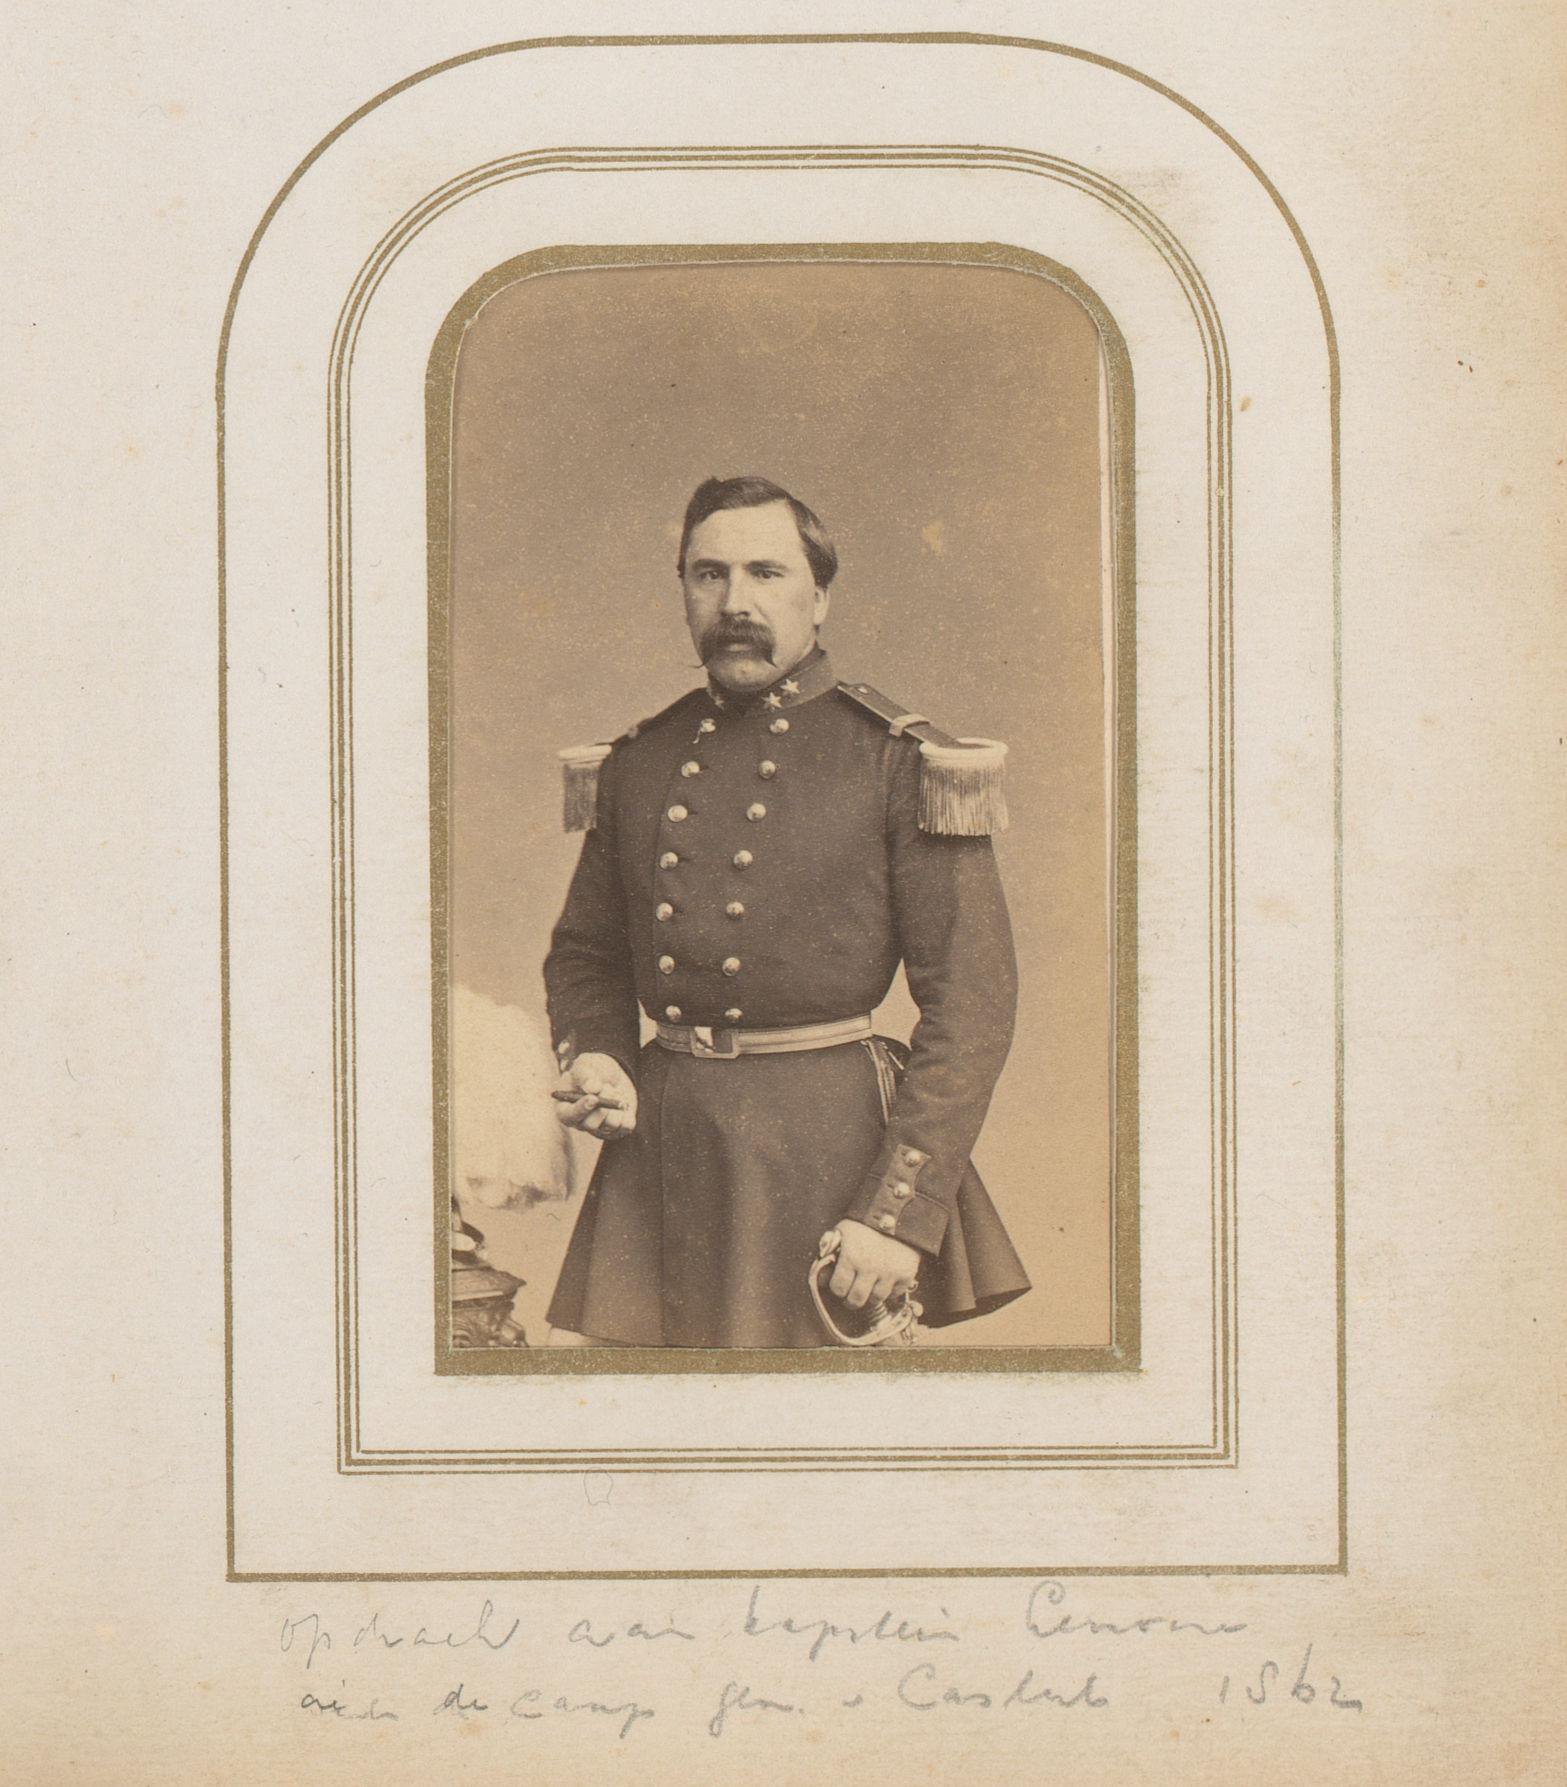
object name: album leaf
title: Portret van een man met zwaard en sigaar in uniform met medailles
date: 1862-1863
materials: cardboard, photographic support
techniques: albumen print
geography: brussels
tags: historical persons, hacking and thrusting weapons: sword, medals and other marks of military honour, (military) uniforms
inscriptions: annotation: ‘opdracht aan kapitein Lemoine/ aide du camp gen v Casteel 1862’, inscription: ‘Atelier de Photographe de/ J. Hallez/ a Dinant/ Admis à l'Exposition internationale de Bruxelles 1875 e à l'Exposition de Paris 1876’, annotation: ‘A mon meilleur ami/ Alexandre Lemoine/ Captaine Aide-de-Camp de général Van Casteel/ Bruxelles, 14 avril 1862/ [...]’